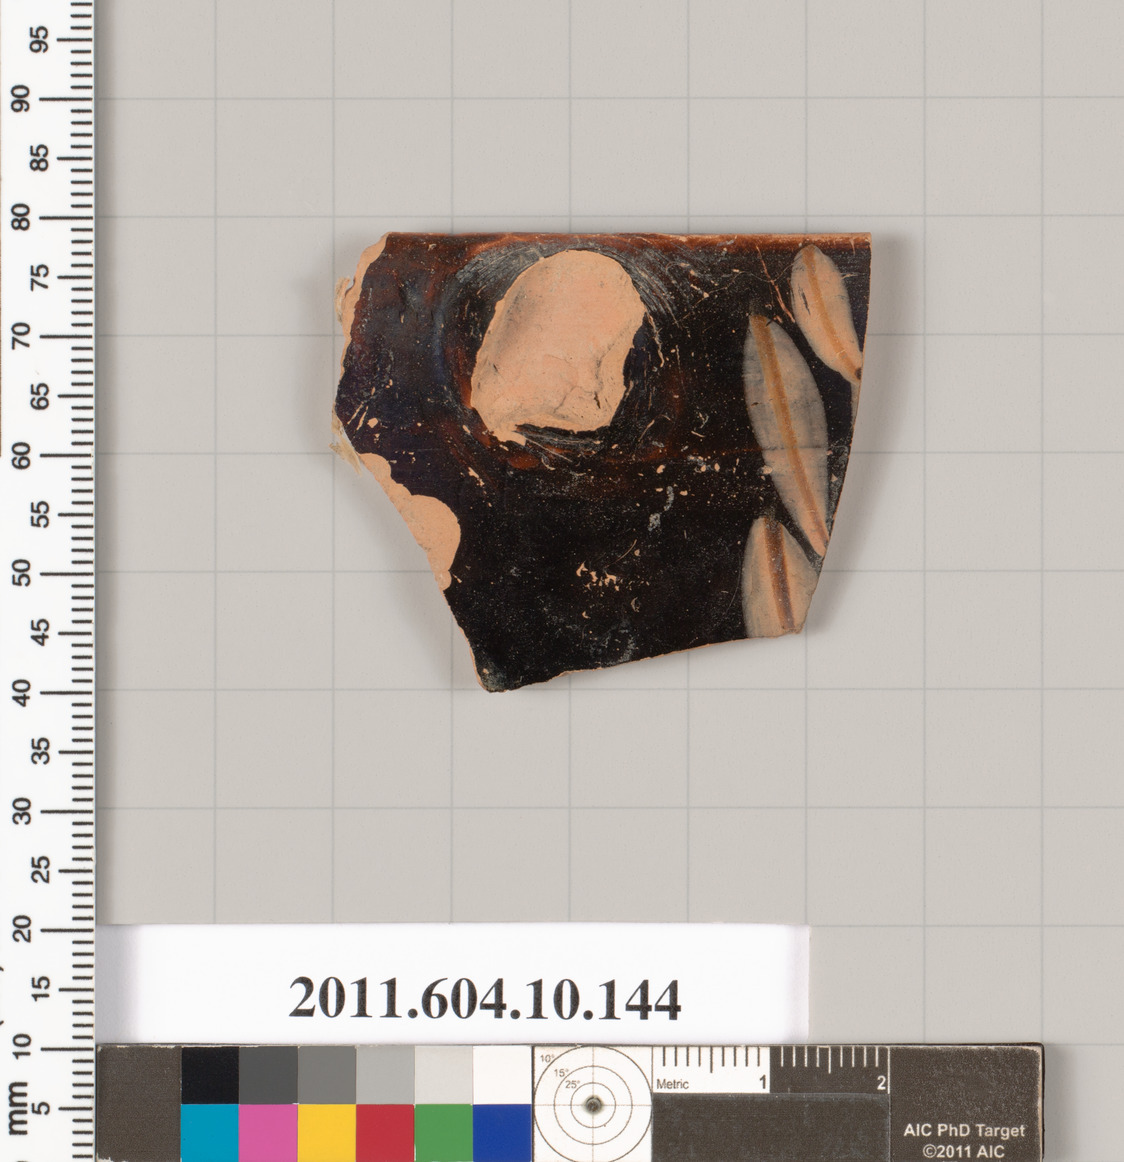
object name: skyphos fragment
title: Terracotta rim fragment of a skyphos (deep drinking cup)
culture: etruscan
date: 434-401 BCE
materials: terracotta